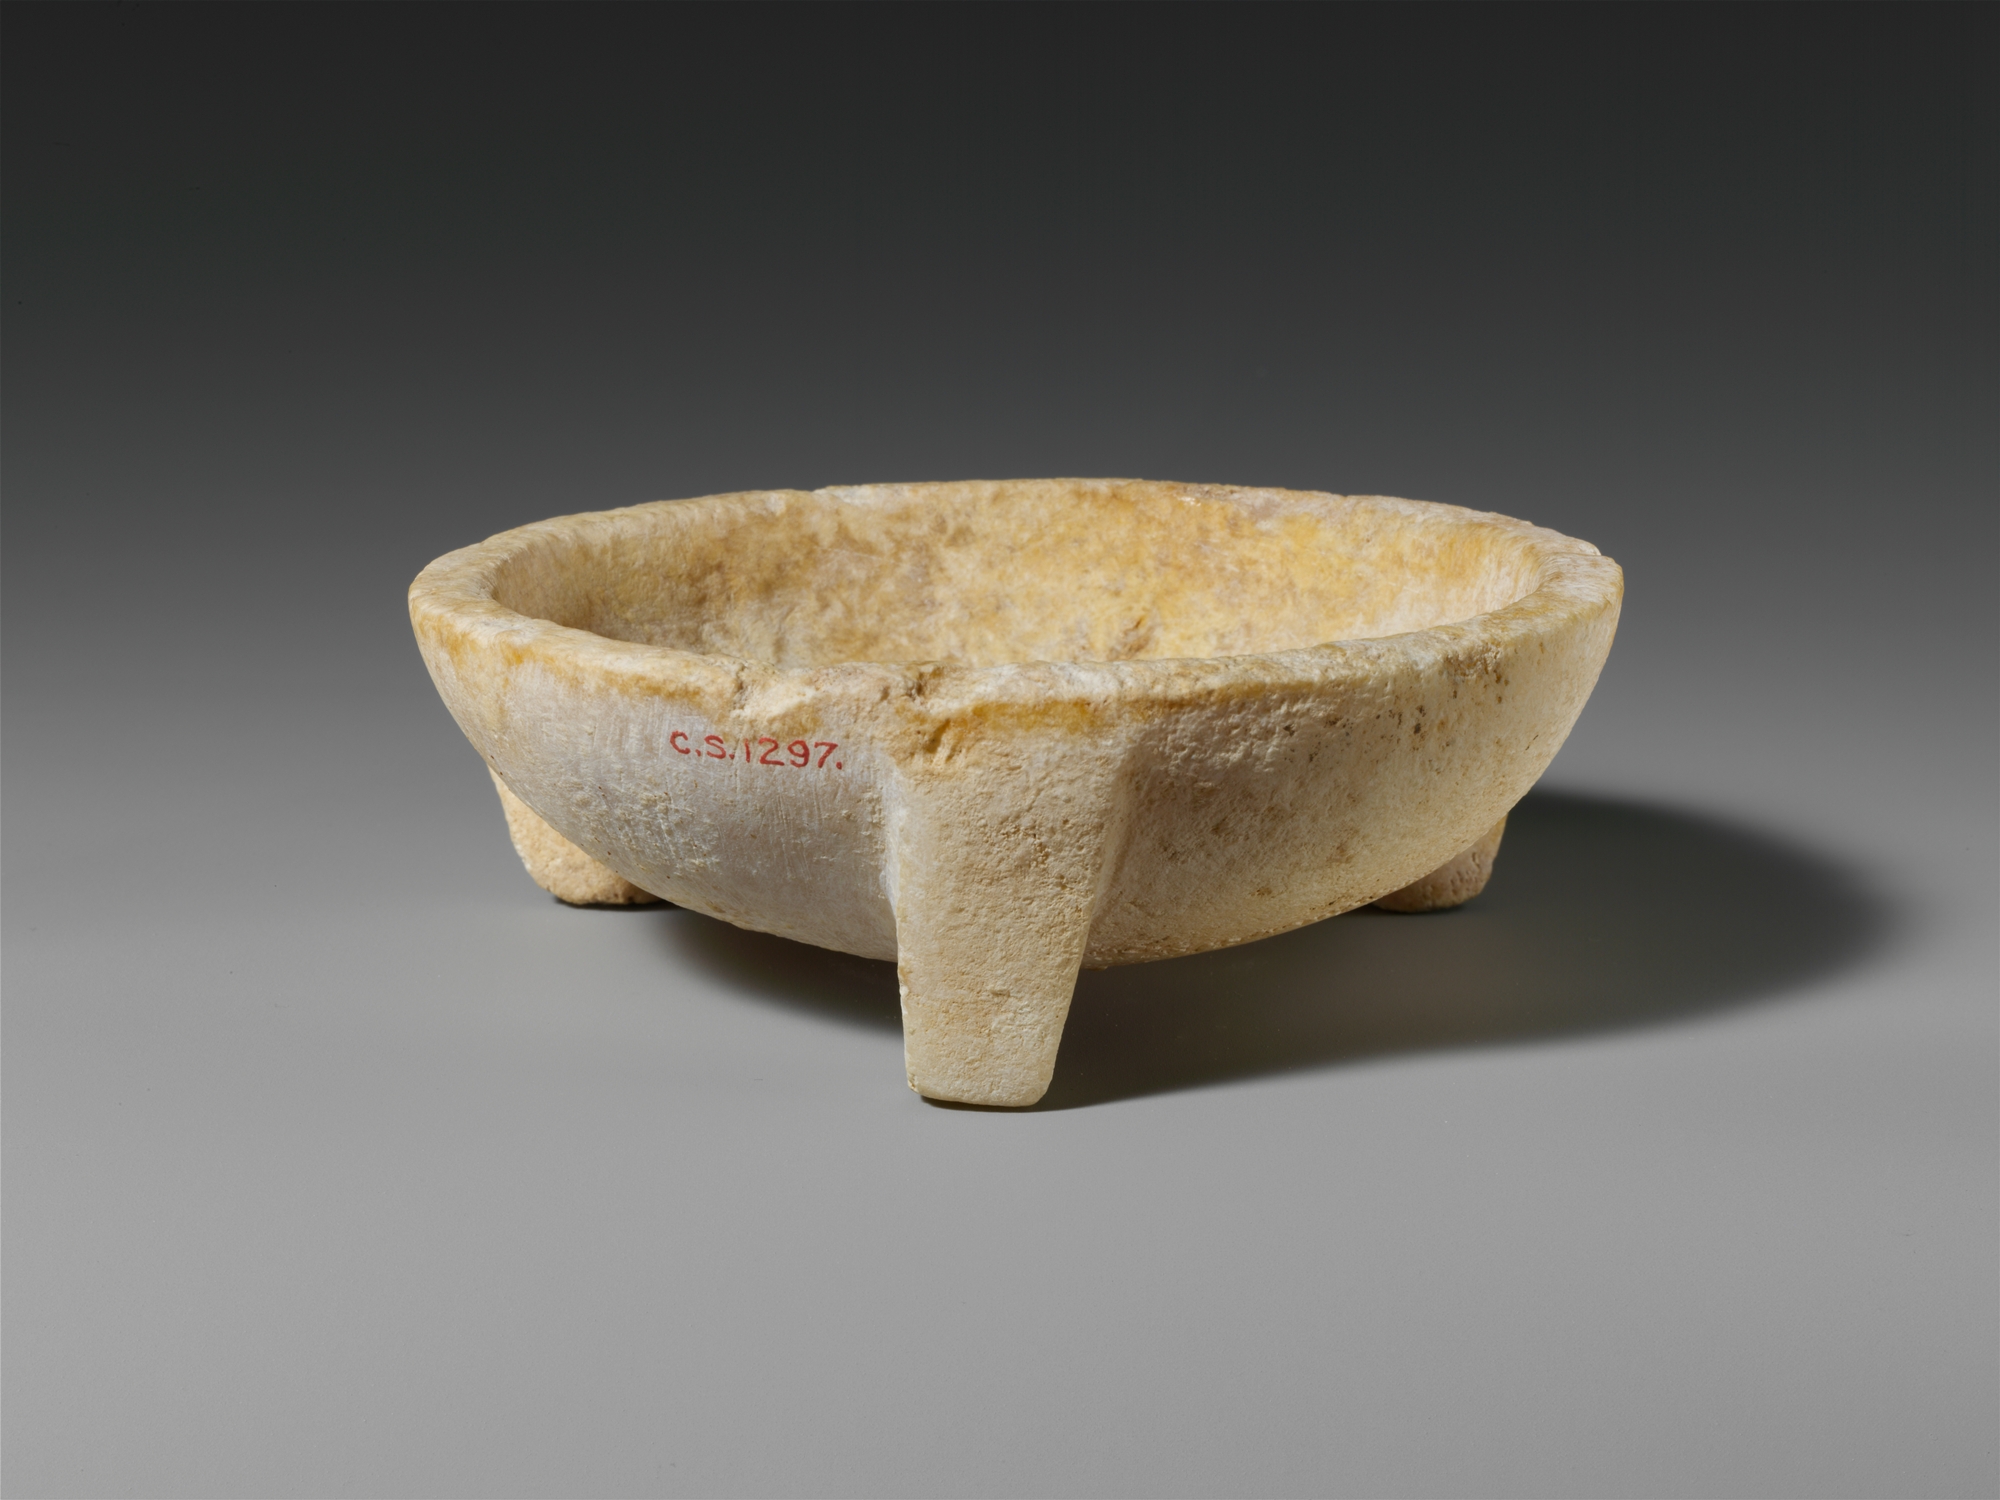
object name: mortar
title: Alabaster mortar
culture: cypriot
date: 1200-1050 BCE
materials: alabaster, gypsum